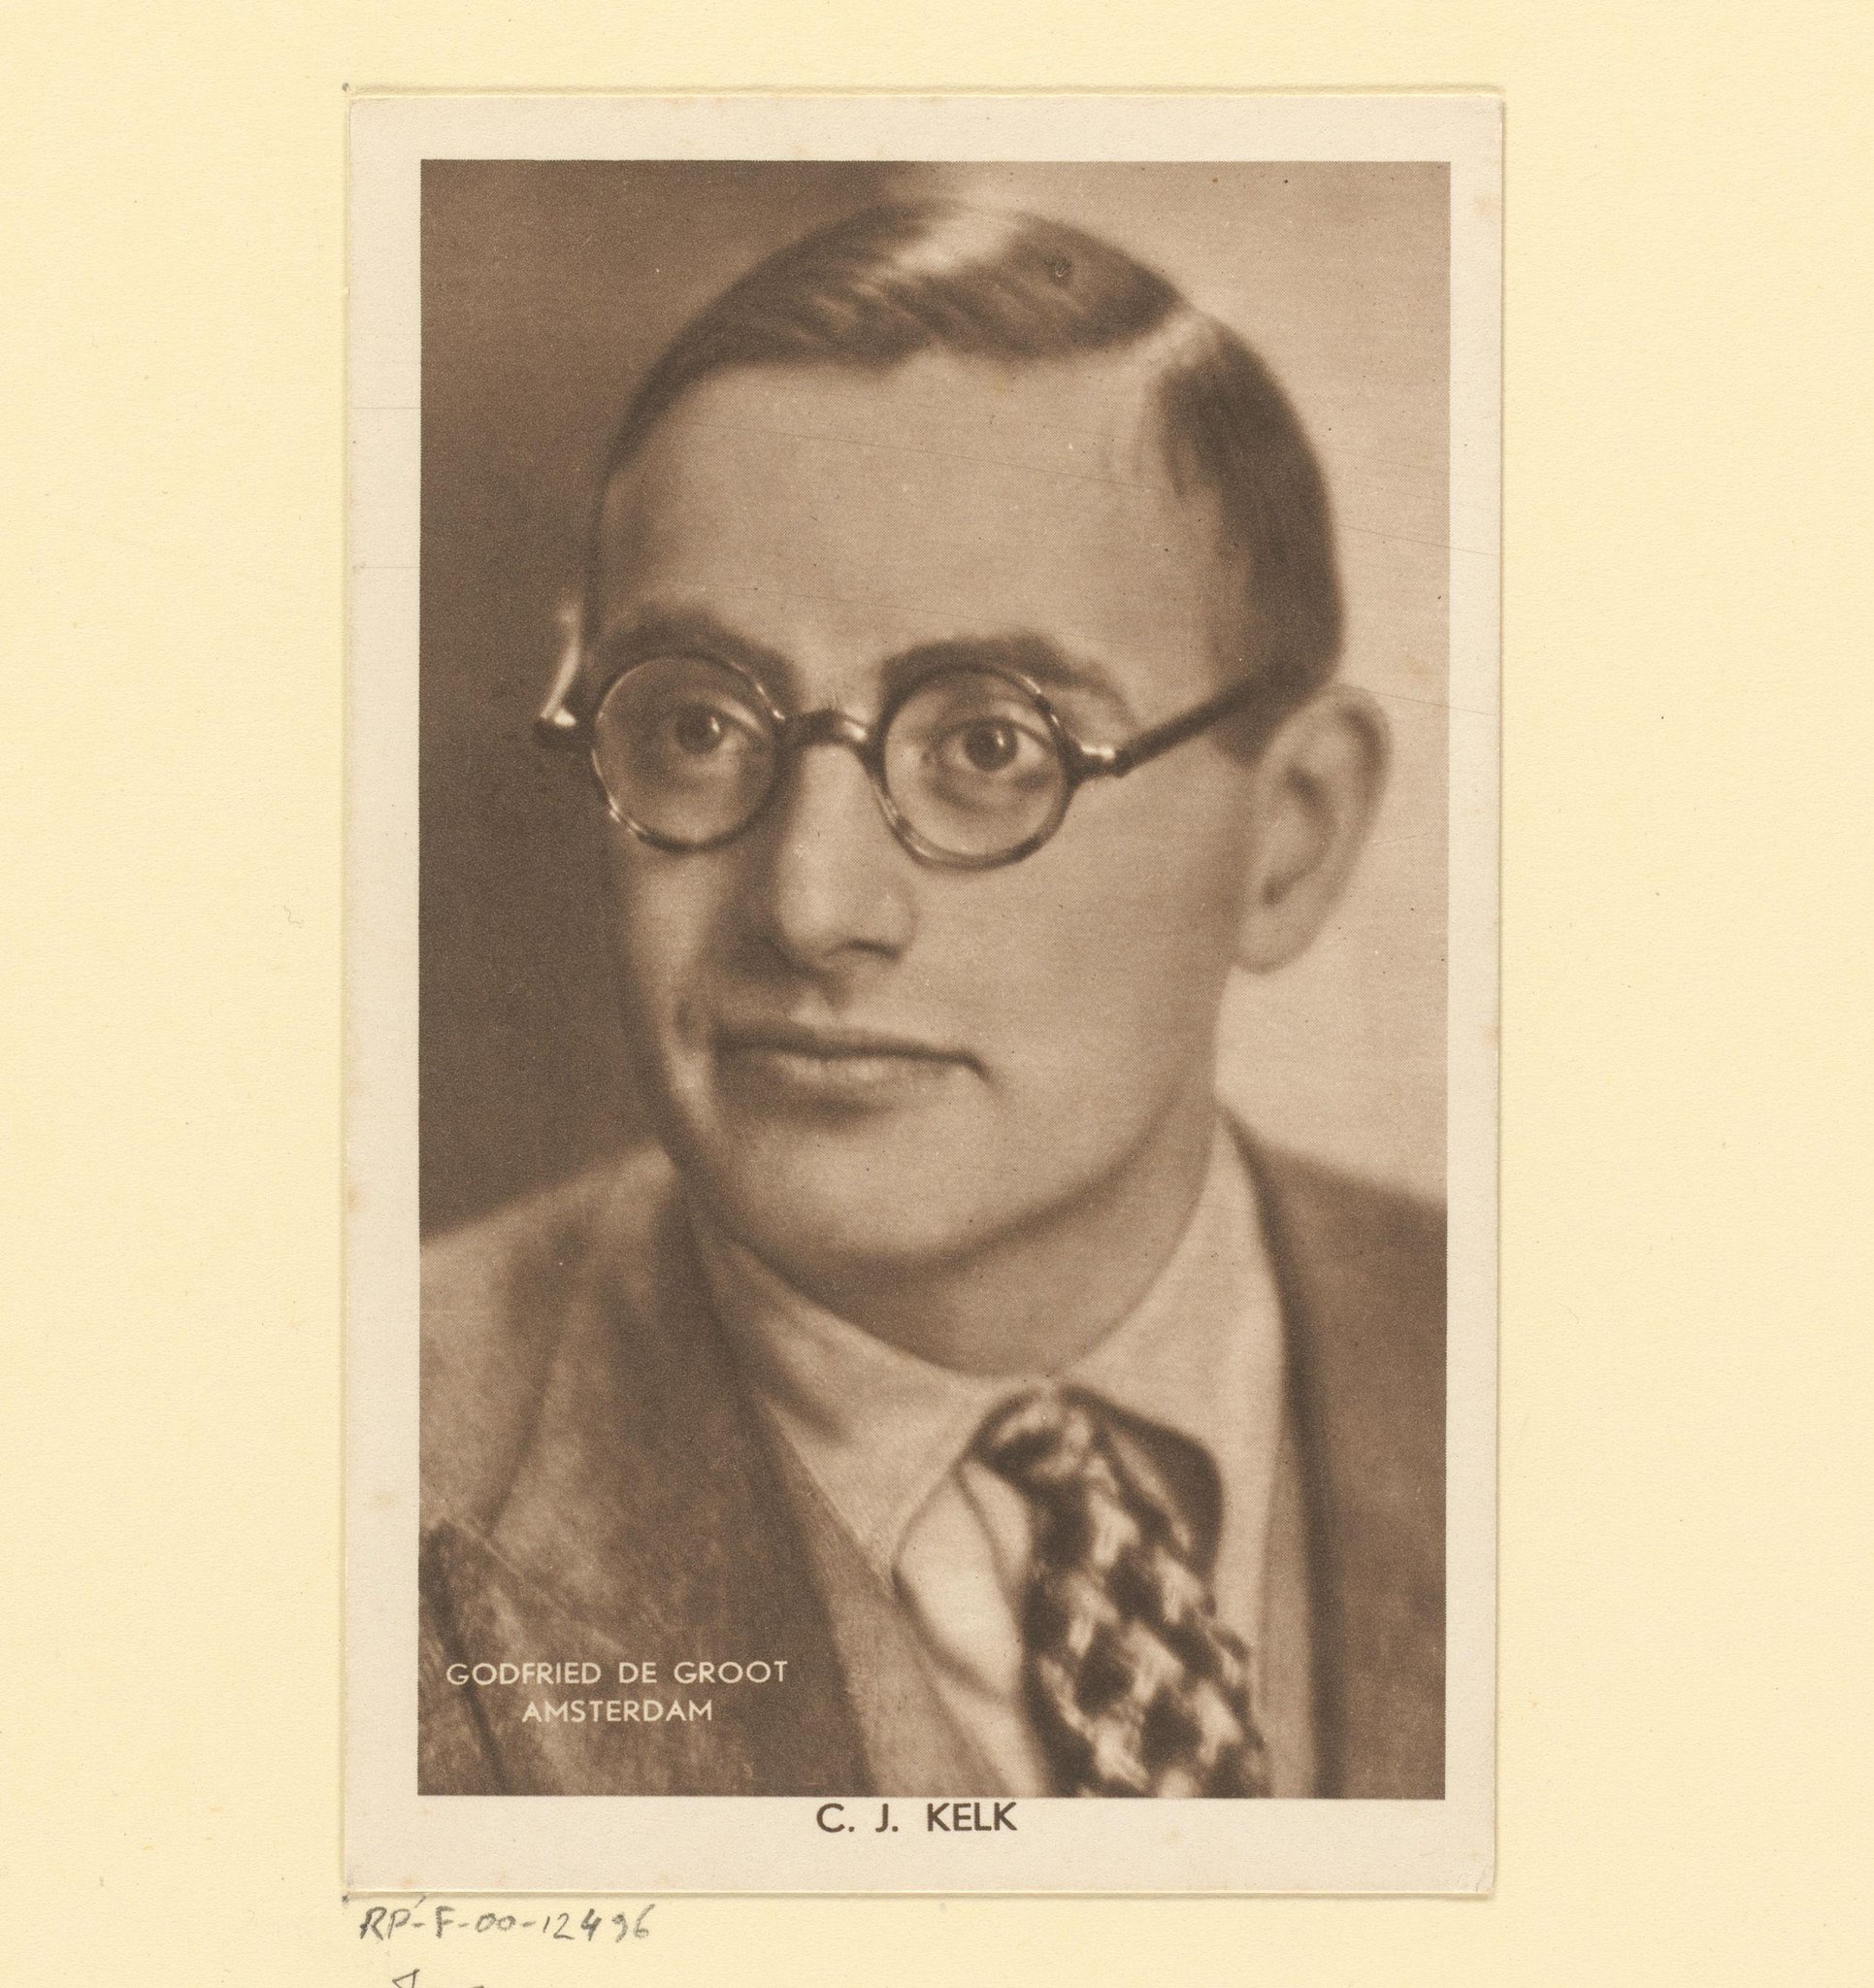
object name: photomechanical print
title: Portret van Cees Kelk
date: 1934-1936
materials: paper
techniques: rotogravure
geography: amsterdam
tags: amsterdam, historical persons